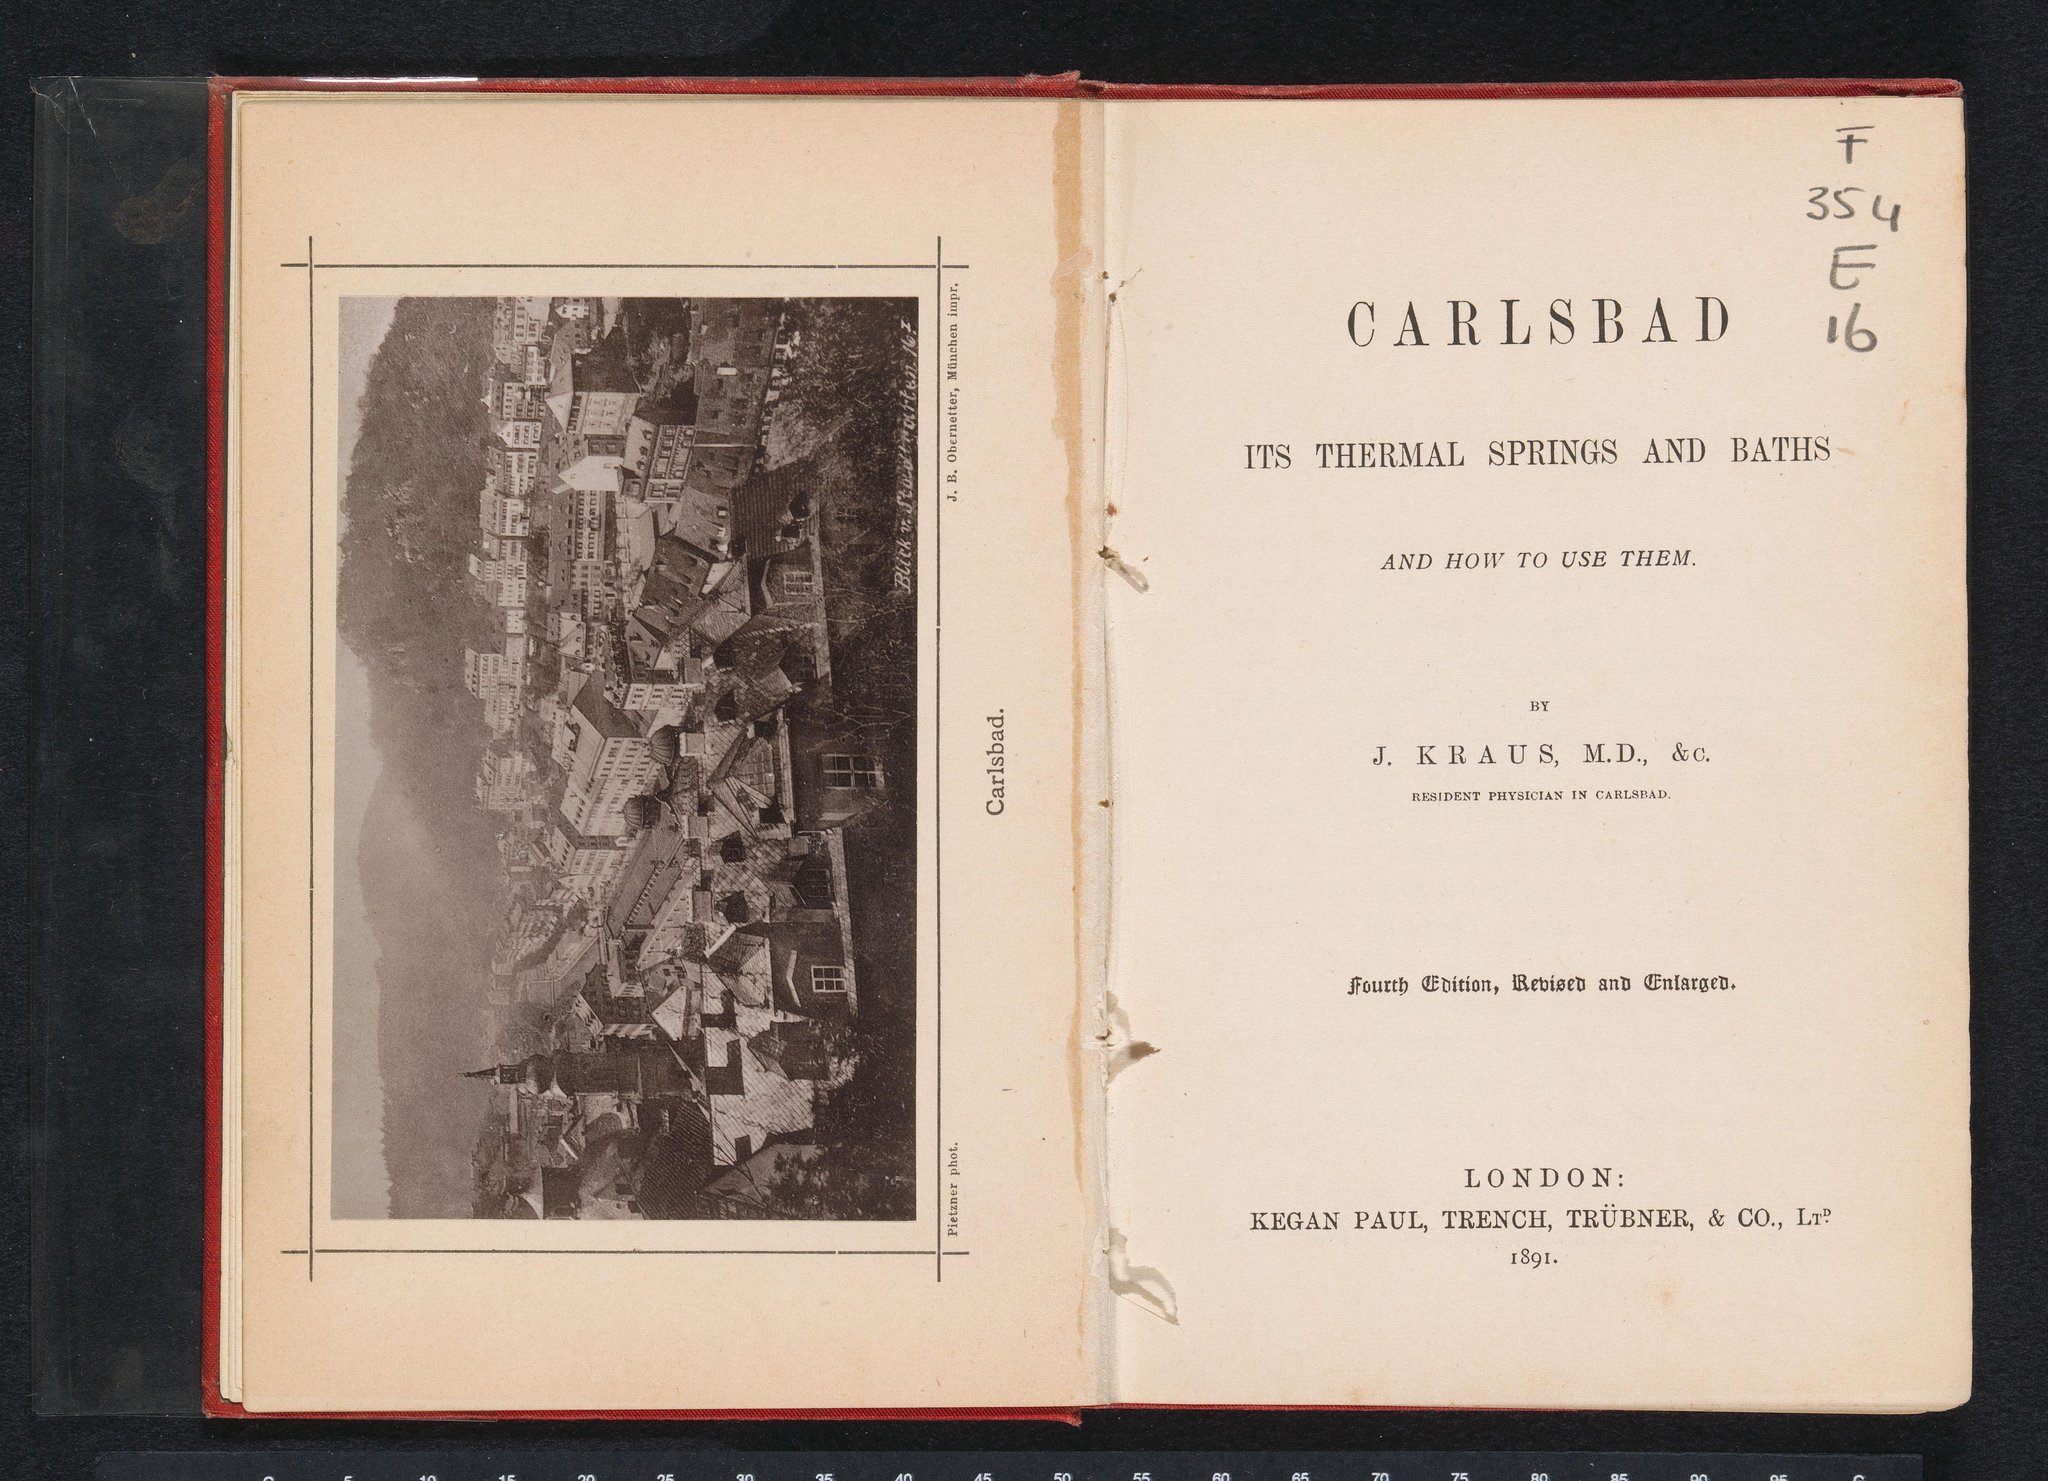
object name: book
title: Carlsbad its thermal springs and baths and how to use them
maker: j. kraus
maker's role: arts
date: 1891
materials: linen, paper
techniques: photograph, printing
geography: london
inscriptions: name: ‘P.D. Briggs.’